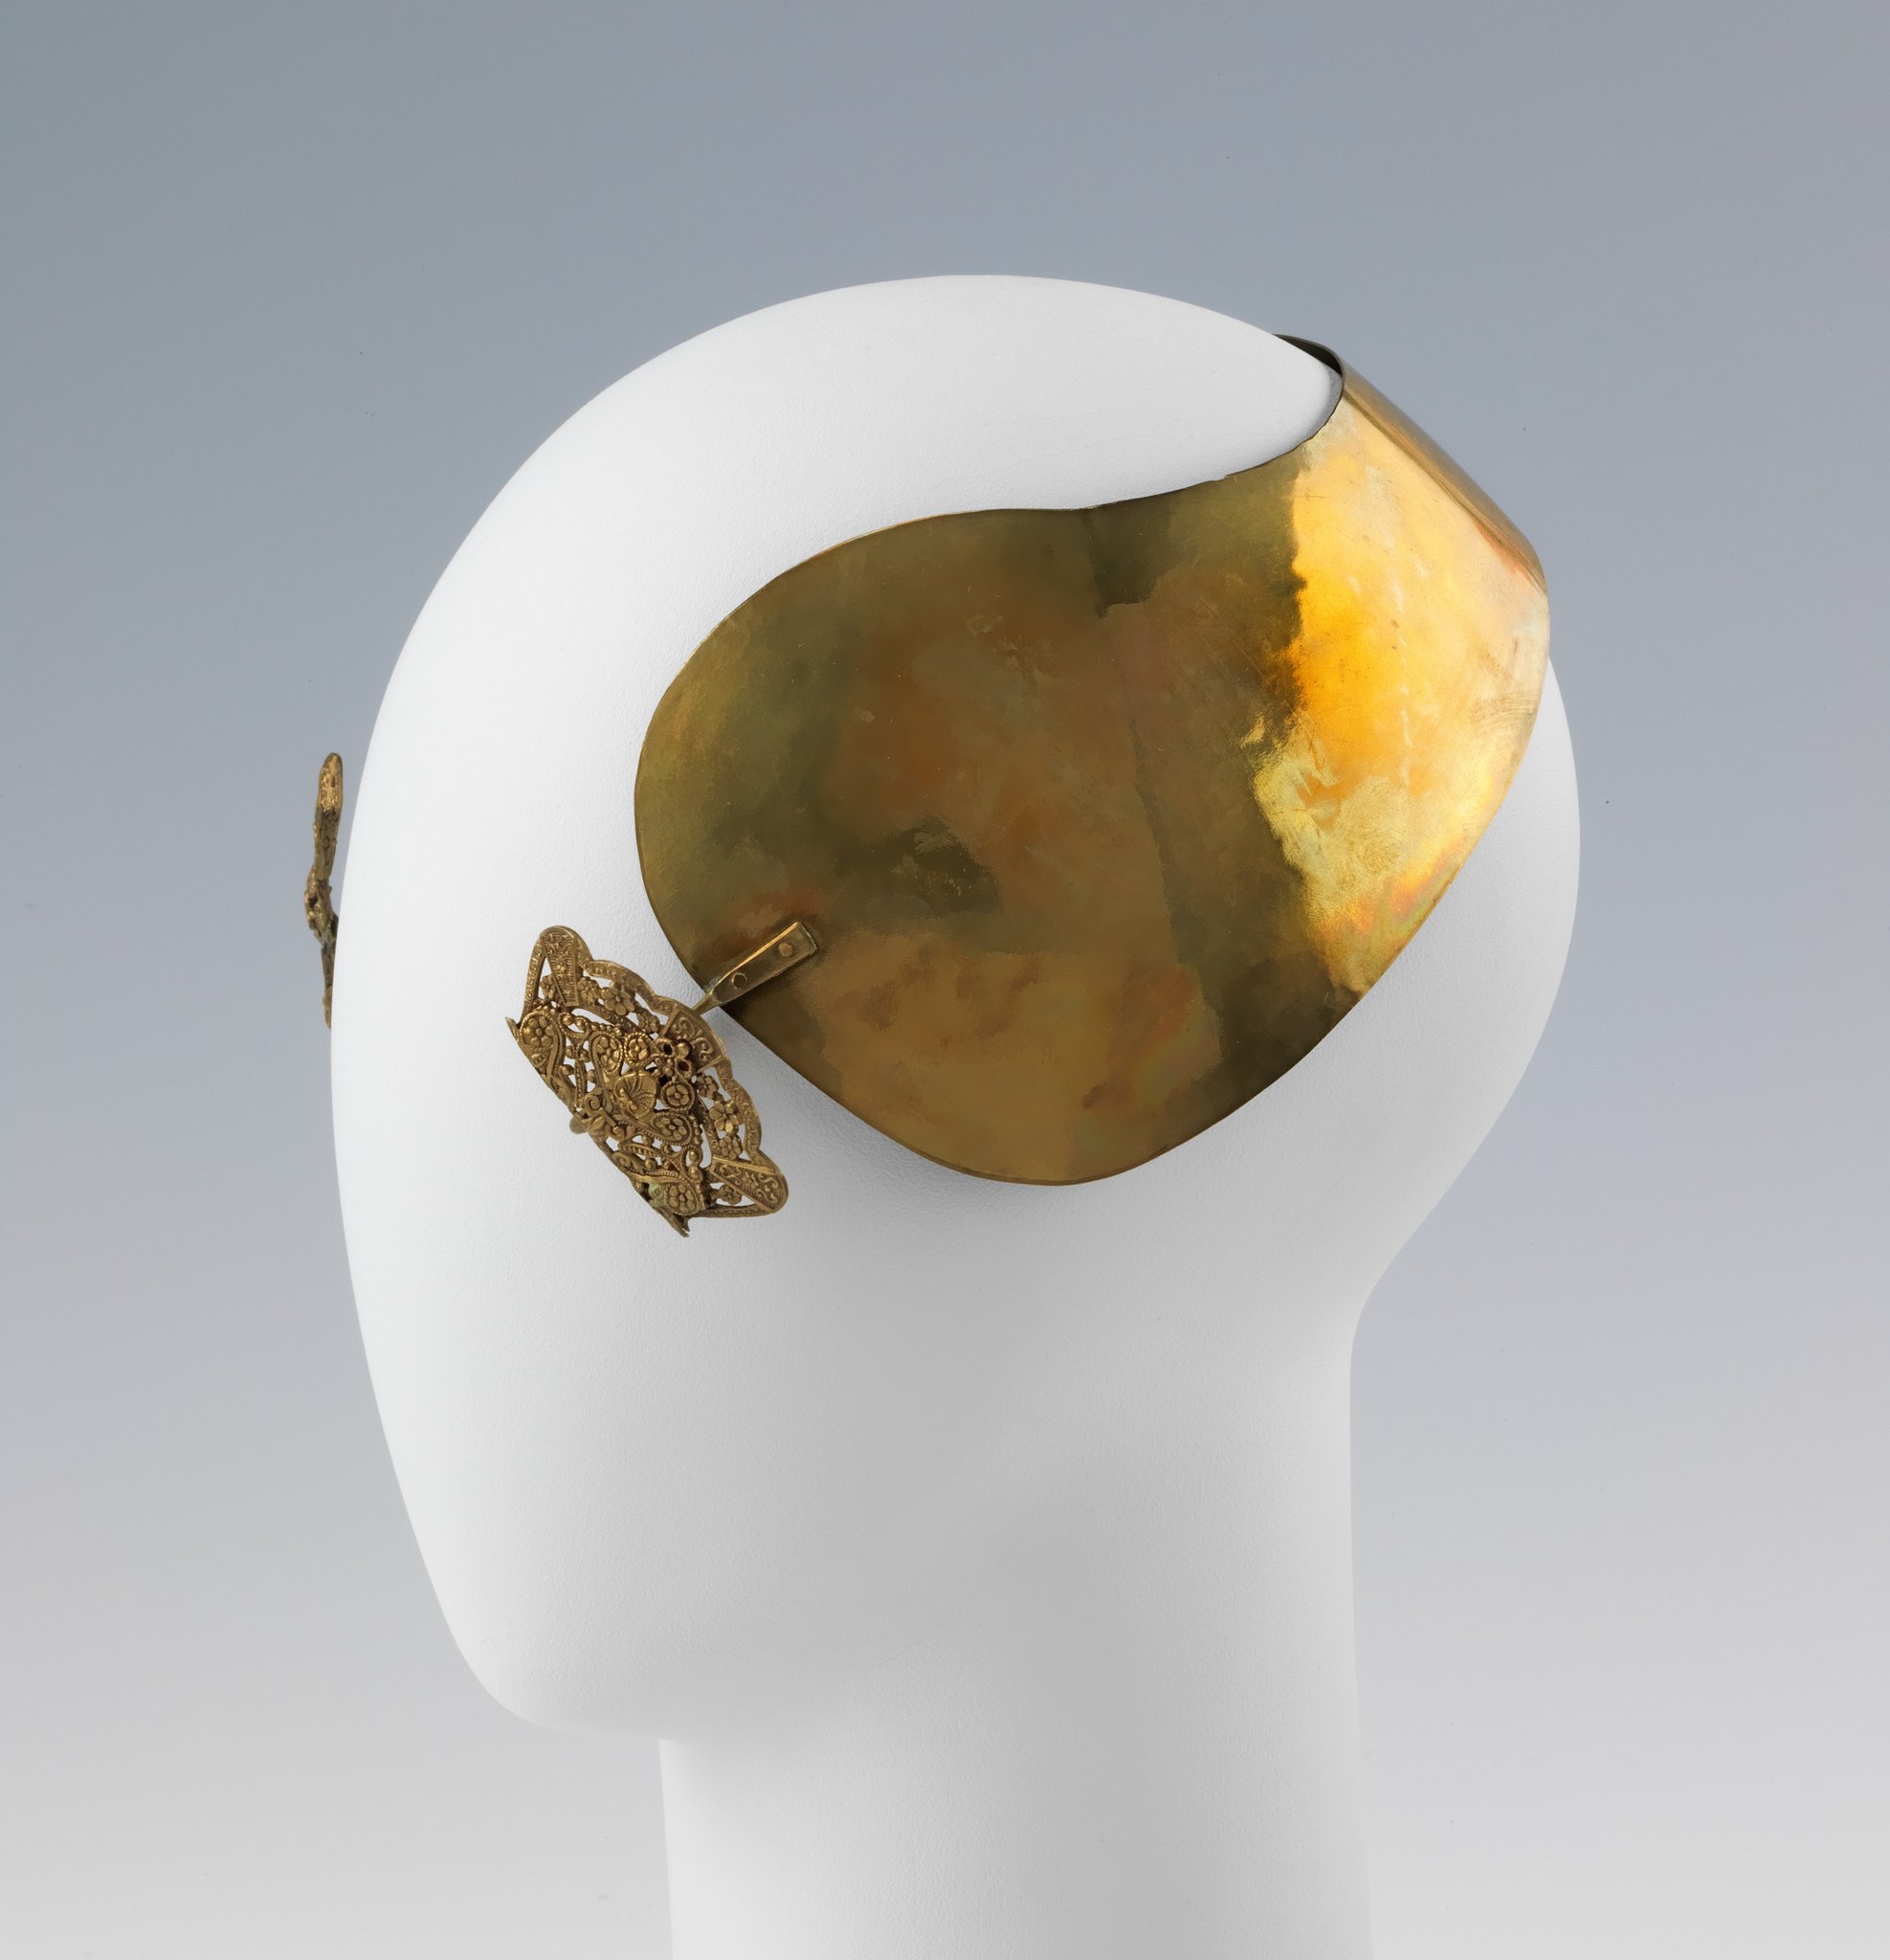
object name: headdress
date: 1876-1900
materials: metal